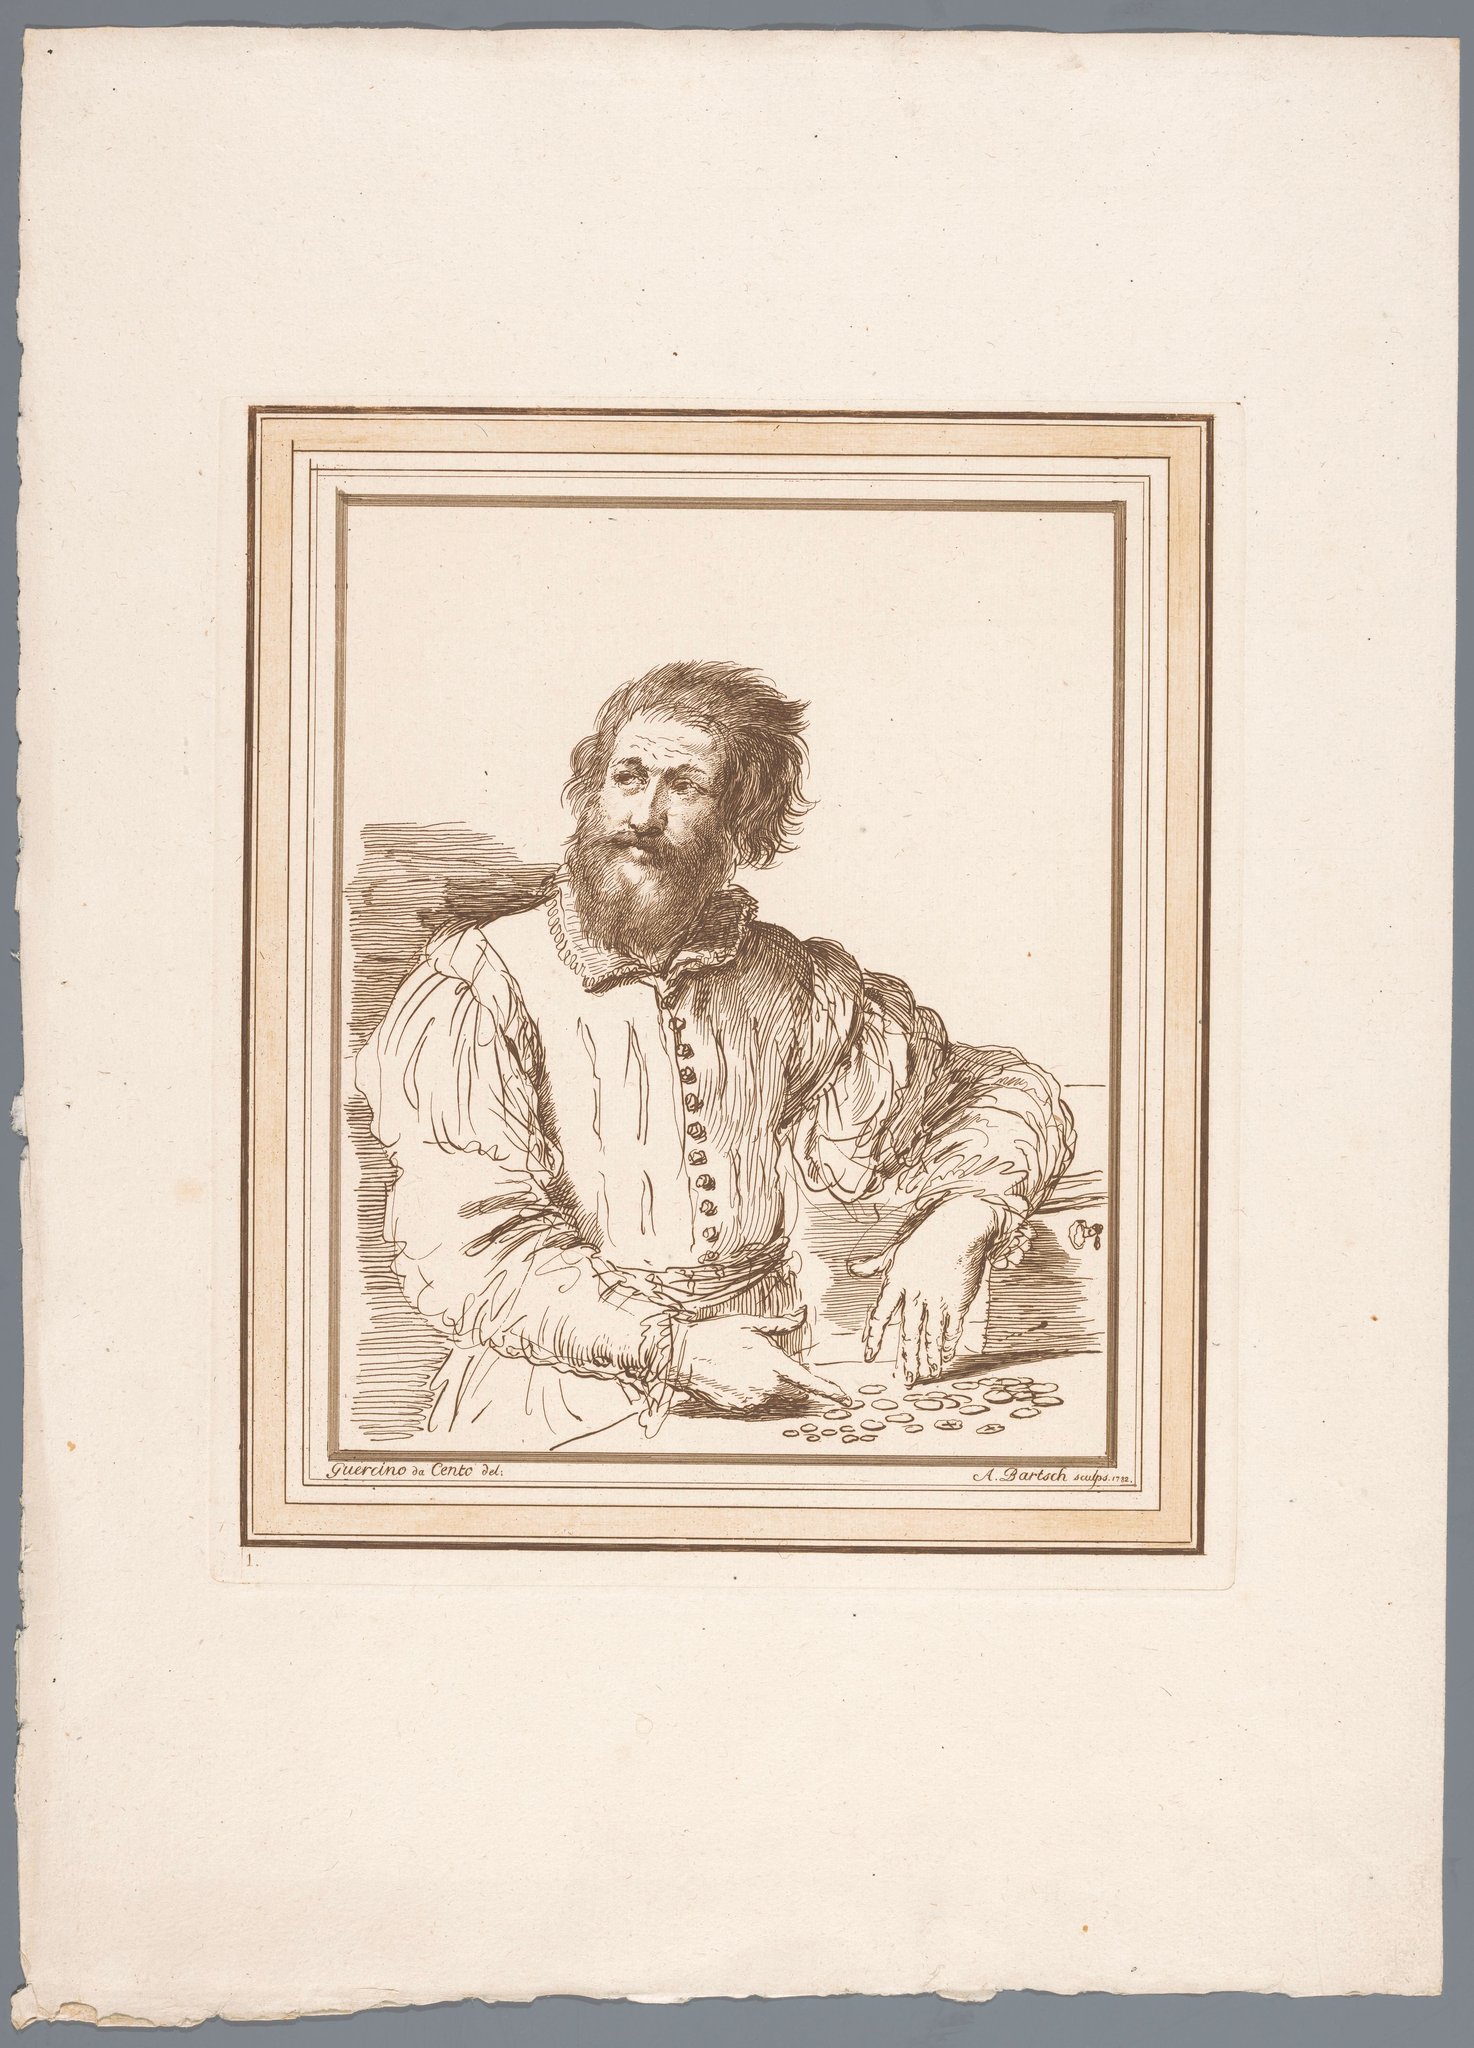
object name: print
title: Recueil d'estampes d'après les desseins originaux, qui se trouvent à la Bibliothèque I. & R. de Vienne (...) Second Cahier contenant six estampes d'apres Jean François Barbieri dit Guercino da Cento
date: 1782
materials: paper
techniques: etching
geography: vienna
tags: coin, beard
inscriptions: collector's mark: Lugt 2228